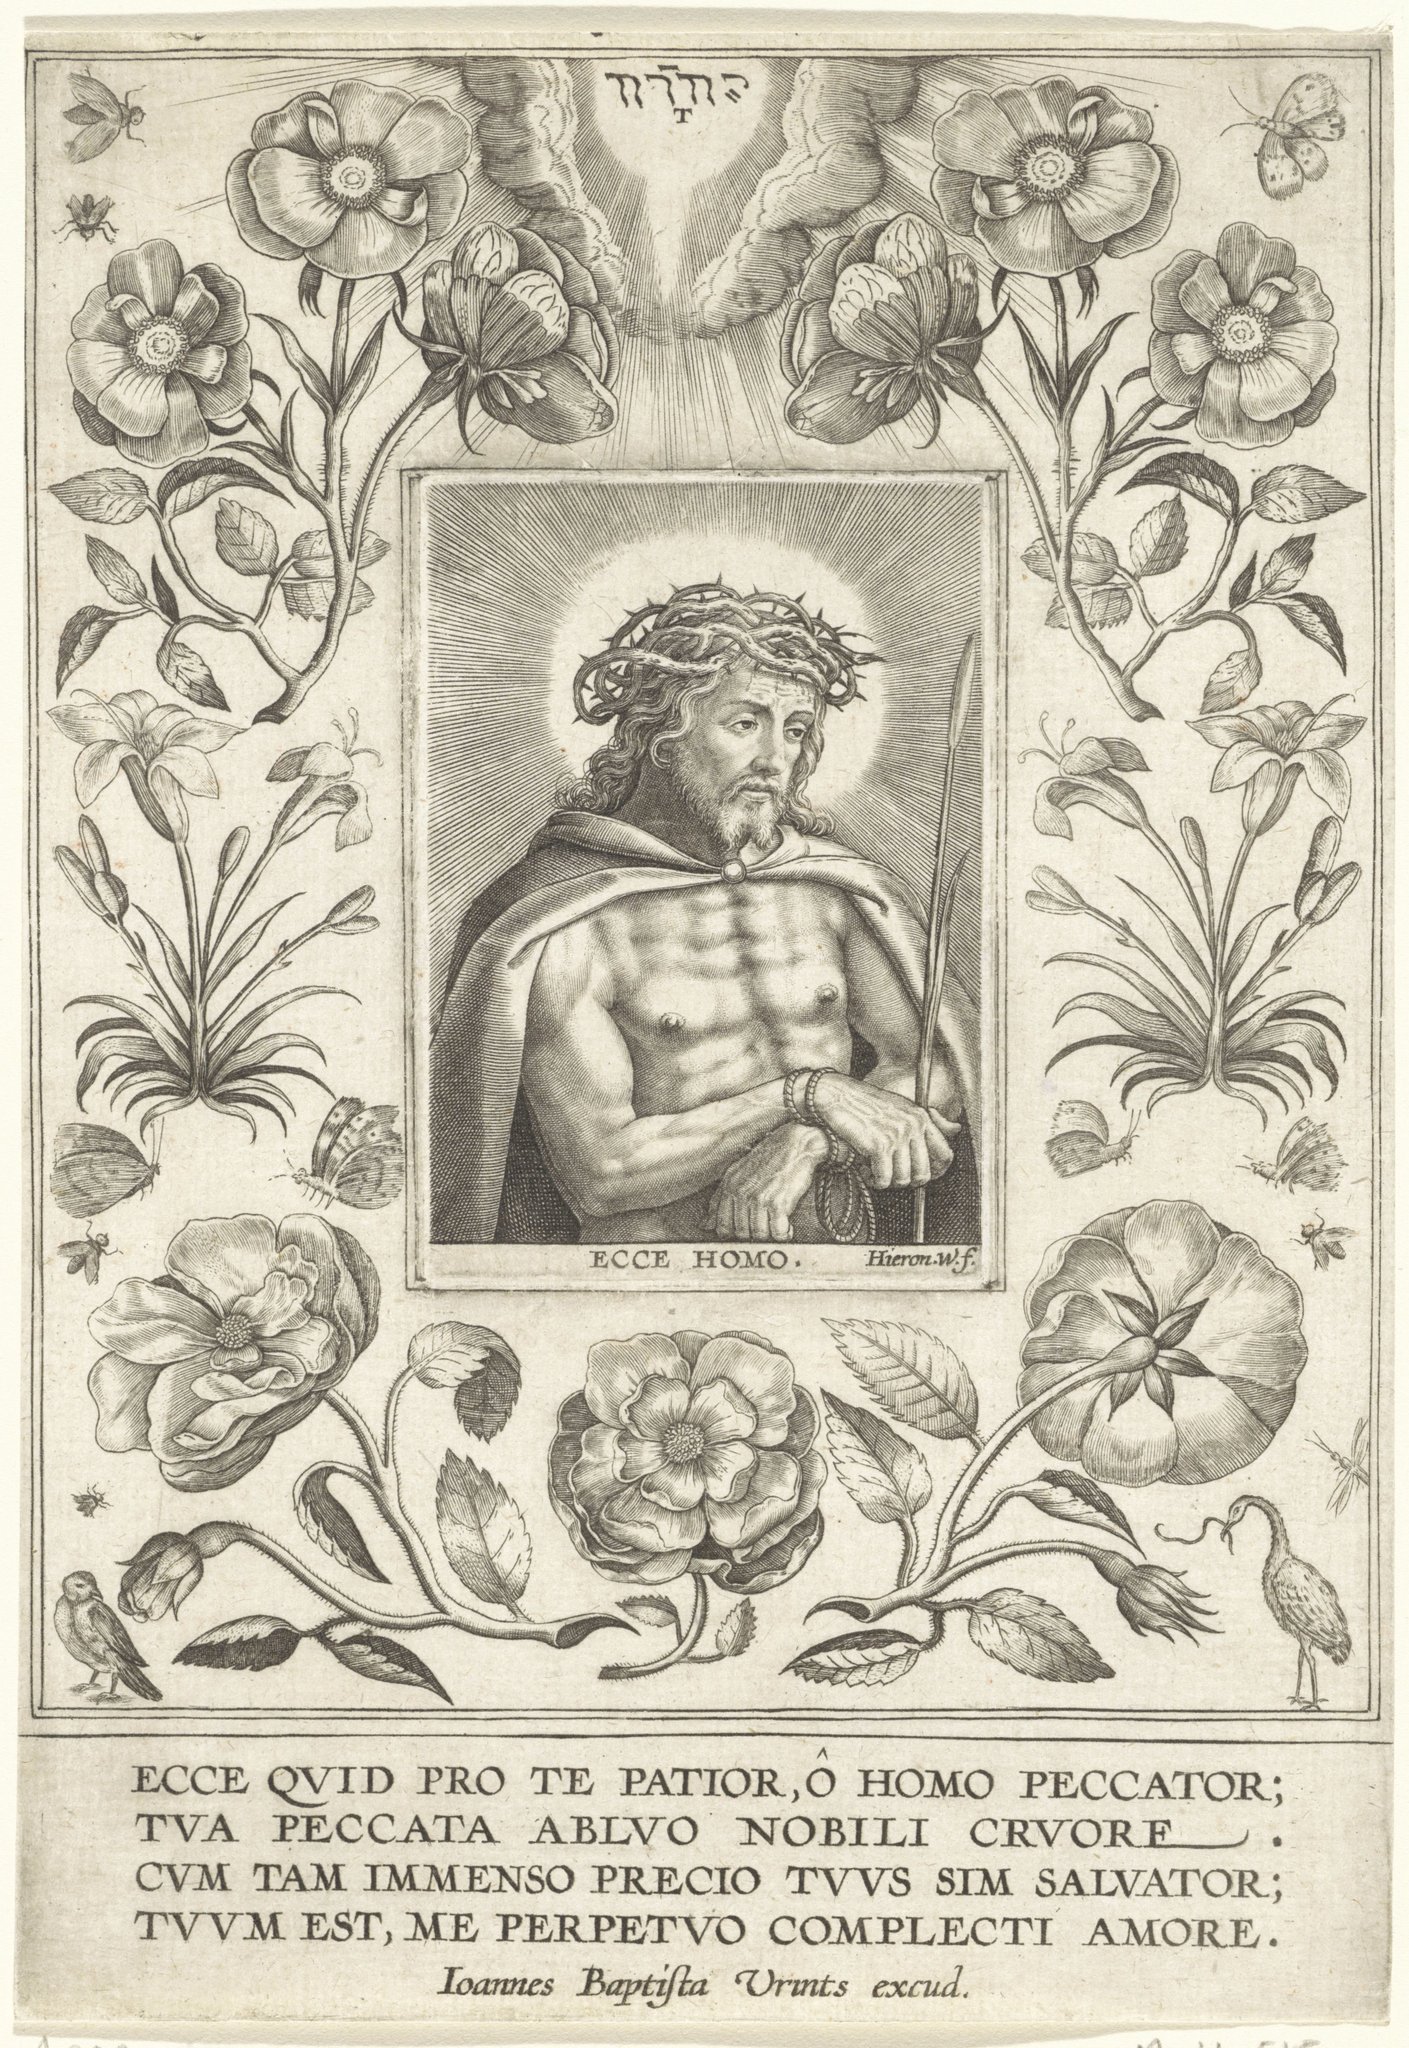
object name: print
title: Christus met de doornenkroon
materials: paper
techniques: engraving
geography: antwerp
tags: flowers, birds, christ alone (also called 'ecce homo'), tetragram (in roman or hebrew script) ~ symbol of god the father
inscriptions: collector's mark: Lugt 2228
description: Christus met de doornenkroon en geboeide handen. Hij houdt een rietstengel vast. De voorstelling is gevat in een ornamentele omlijsting die is versierd met bloemen, insecten en vogels, geheel bovenaan een tetragram als symbool van God de Vader. In de marge een vierregelig onderschrift in het Latijn.